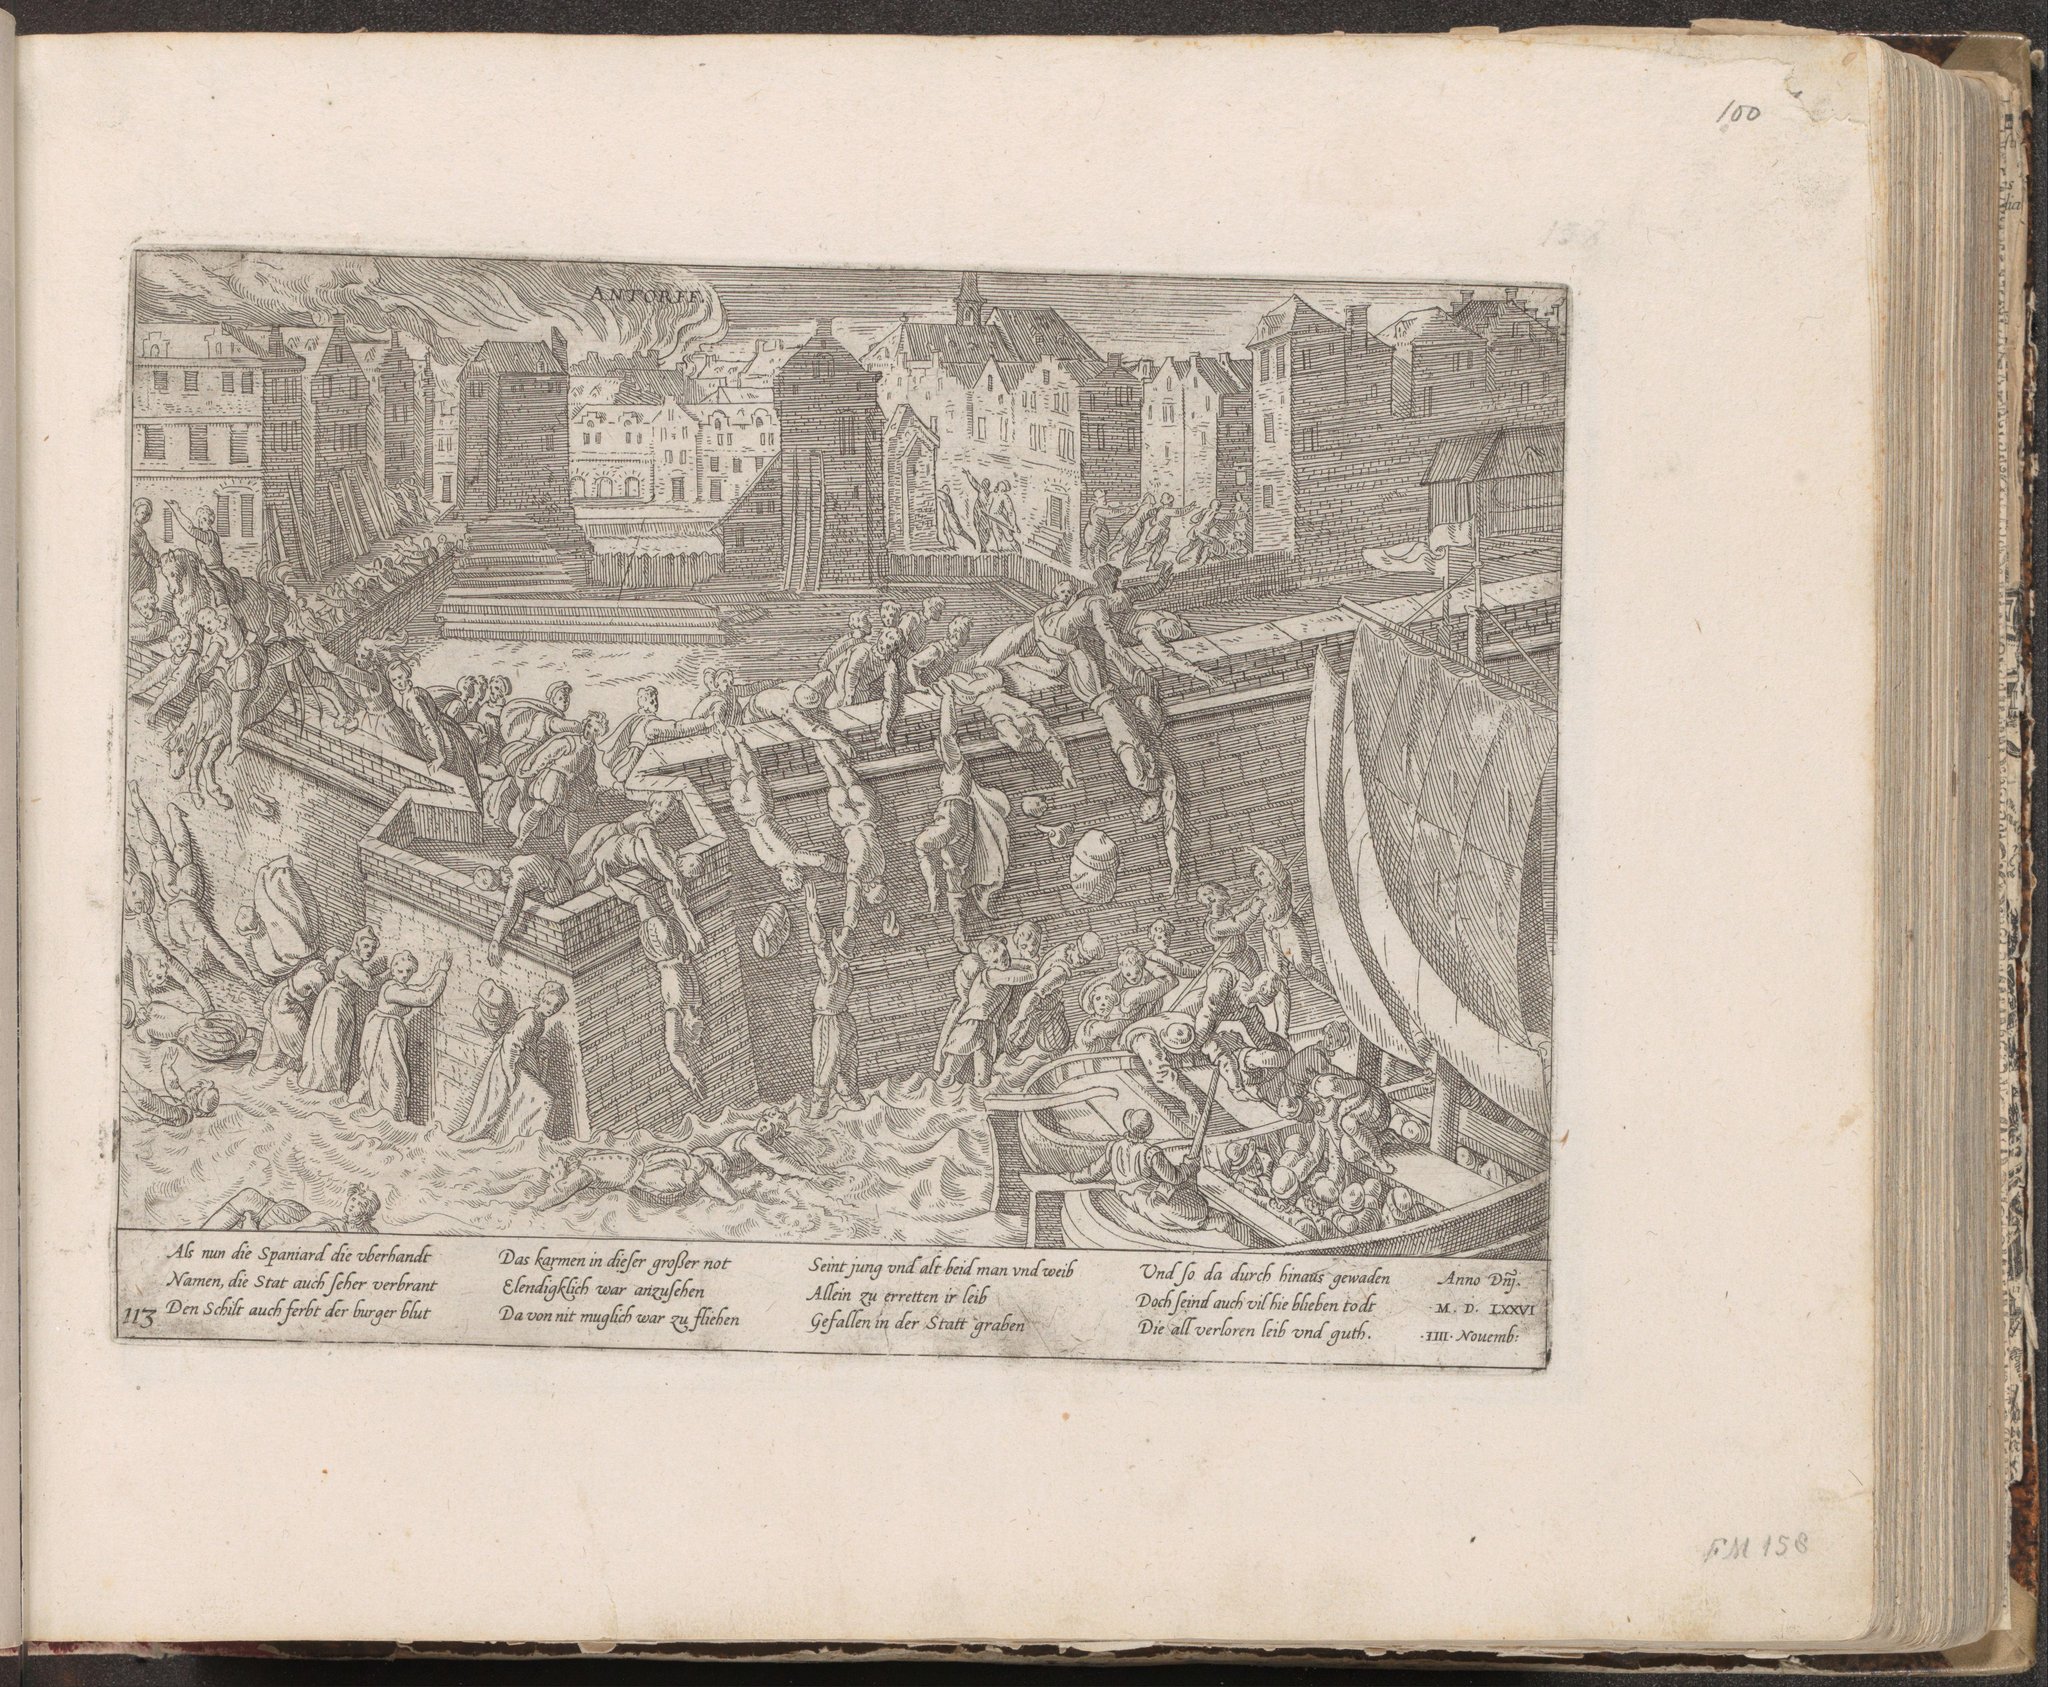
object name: history print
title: Serie 7: Nederlandse Gebeurtenissen, 1576-1577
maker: frans hogenberg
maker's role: print maker, publisher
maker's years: 1538-1590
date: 1576-1579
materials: paper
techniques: etching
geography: cologne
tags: massacre ~ war, antwerp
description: Spaanse Furie te Antwerpen, 4-7 november 1576. In een poging aan het geweld te ontsnappen springen Antwerpenaren in de Schelde en proberen te vluchten in bootjes. Met onderschrift van 12 regels in het Duits. Genummerd: 113. De prent maakt deel uit van een album.